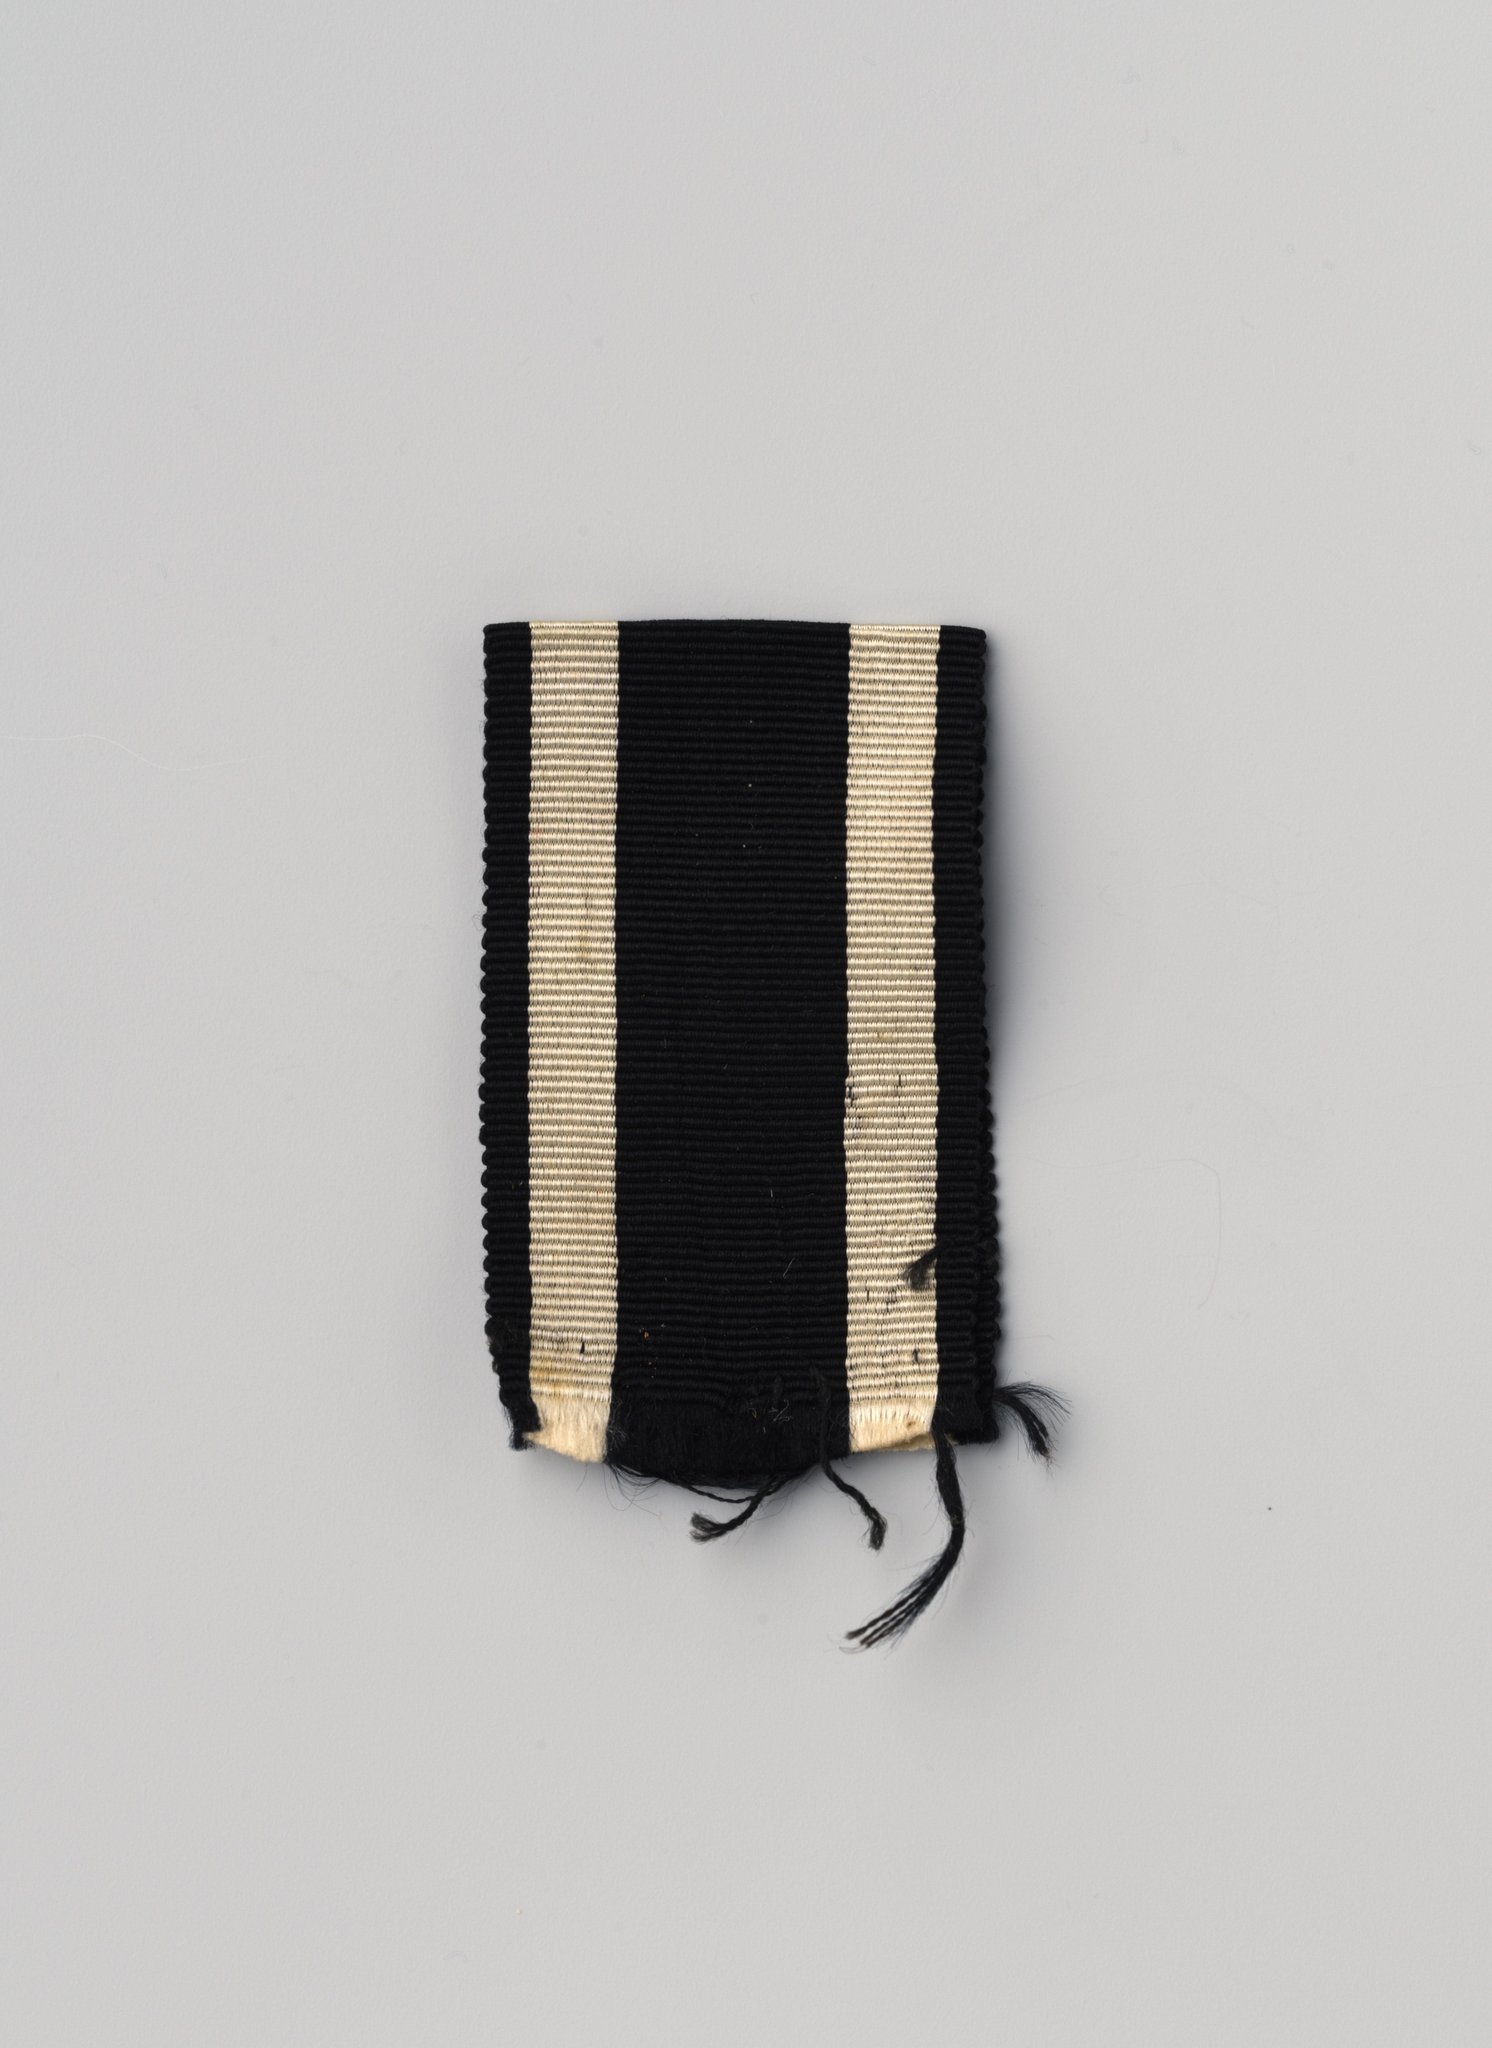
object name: onderscheidingsteken, onderscheiding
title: Lint, zwart-wit gestreept, horend bij een onderscheiding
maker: Anonymous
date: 1900-1925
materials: silk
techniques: weave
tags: eugen wachenheimer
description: Dit object is onderdeel van de nalatenschap van Isabel Elon-Wachenheimer (1928-2010). Tot haar overlijden behoorde het samen met de andere objecten uit de nalatenschap tot haar privédomein van Isabel Wachenheimer. In die particuliere context zijn deze objecten tezamen en individueel aandenkens - aan de jeugd, ouders en familie van Isabel Wachenheimer vóór en tijdens de Shoah en aan haar leven na de Tweede Wereldoorlog. Isabel Wachenheimer, die van juni 1943 tot mei 1945 gevangen zat in Kamp Westerbork, Theresienstadt, Auschwitz, Lenzing a/d Oberdonau (een buitenkamp van Mauthausen), overleefde de Shoah. Haar ouders – Eugène Wachenheimer en Else Wachenheimer-Moos - werden op 14 oktober 1944 in Auschwitz-Birkenau vermoord.